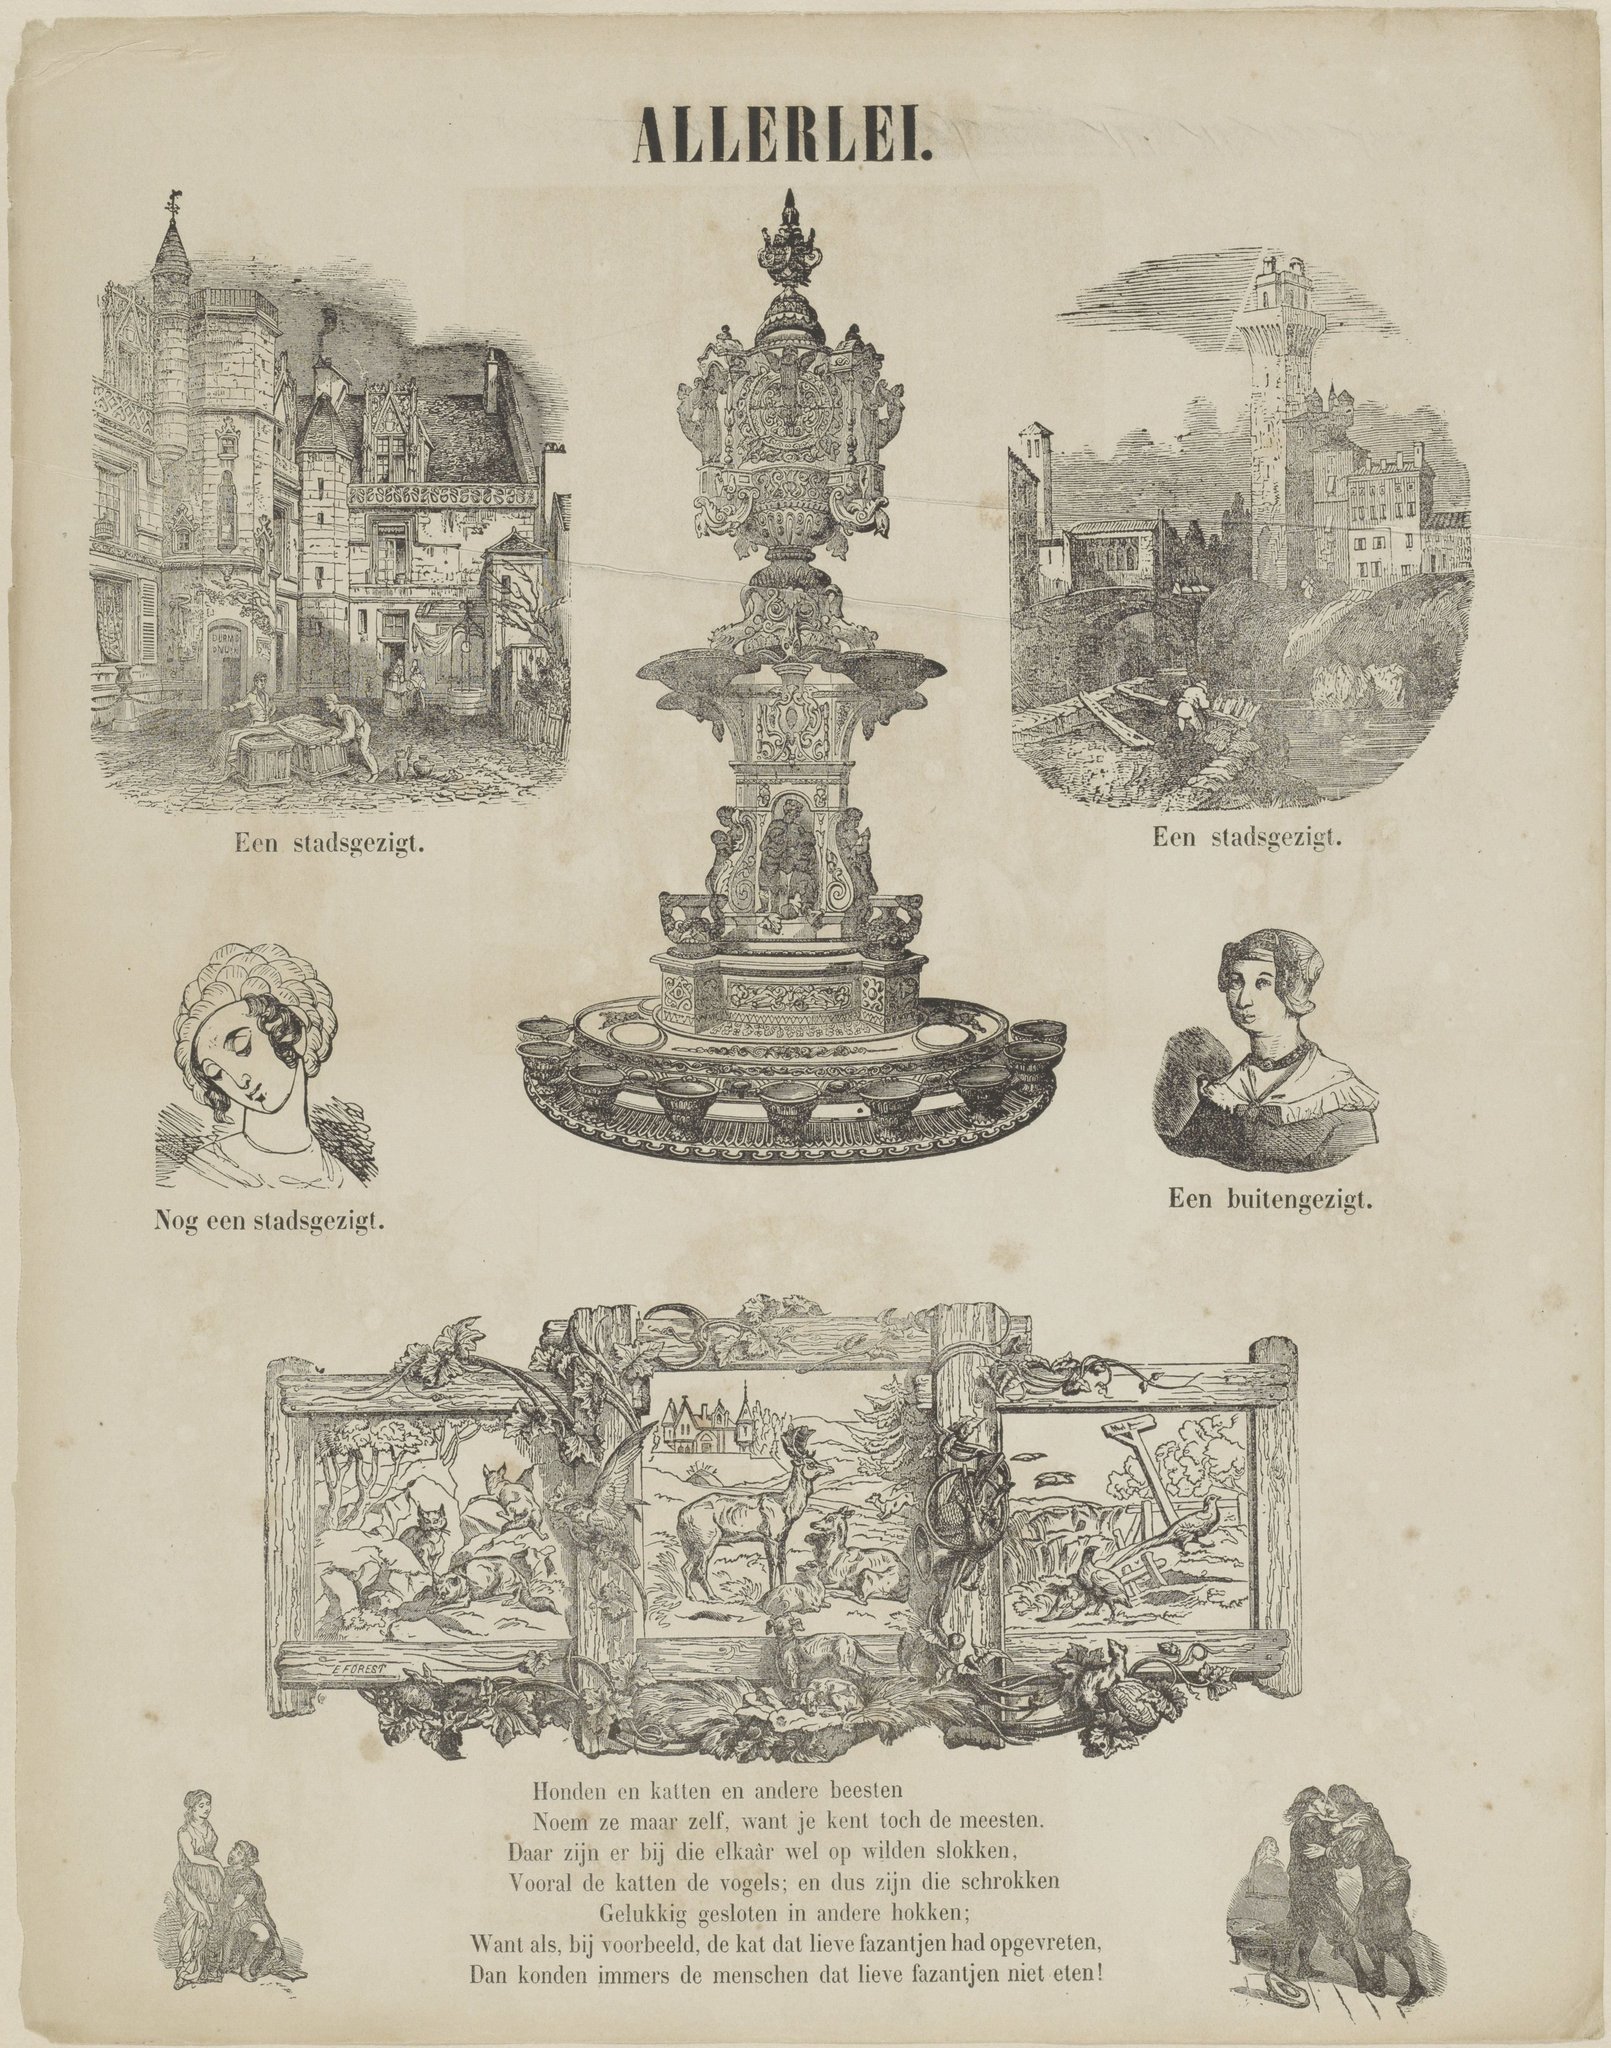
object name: print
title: Allerlei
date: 1861-1929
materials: paper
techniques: letterpress printing, engraving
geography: europe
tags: animals, city-view in general; 'veduta', human types, characters (human types)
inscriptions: collector's mark: Lugt 2760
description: Blad met 8 voorstellingen van verschillende aard, zoals voorstellingen van stadsgezichten, van vrouwen en van dieren. Onder elke afbeelding een onderschrift. Midden onder een zevenregelig vers in boekdruk.